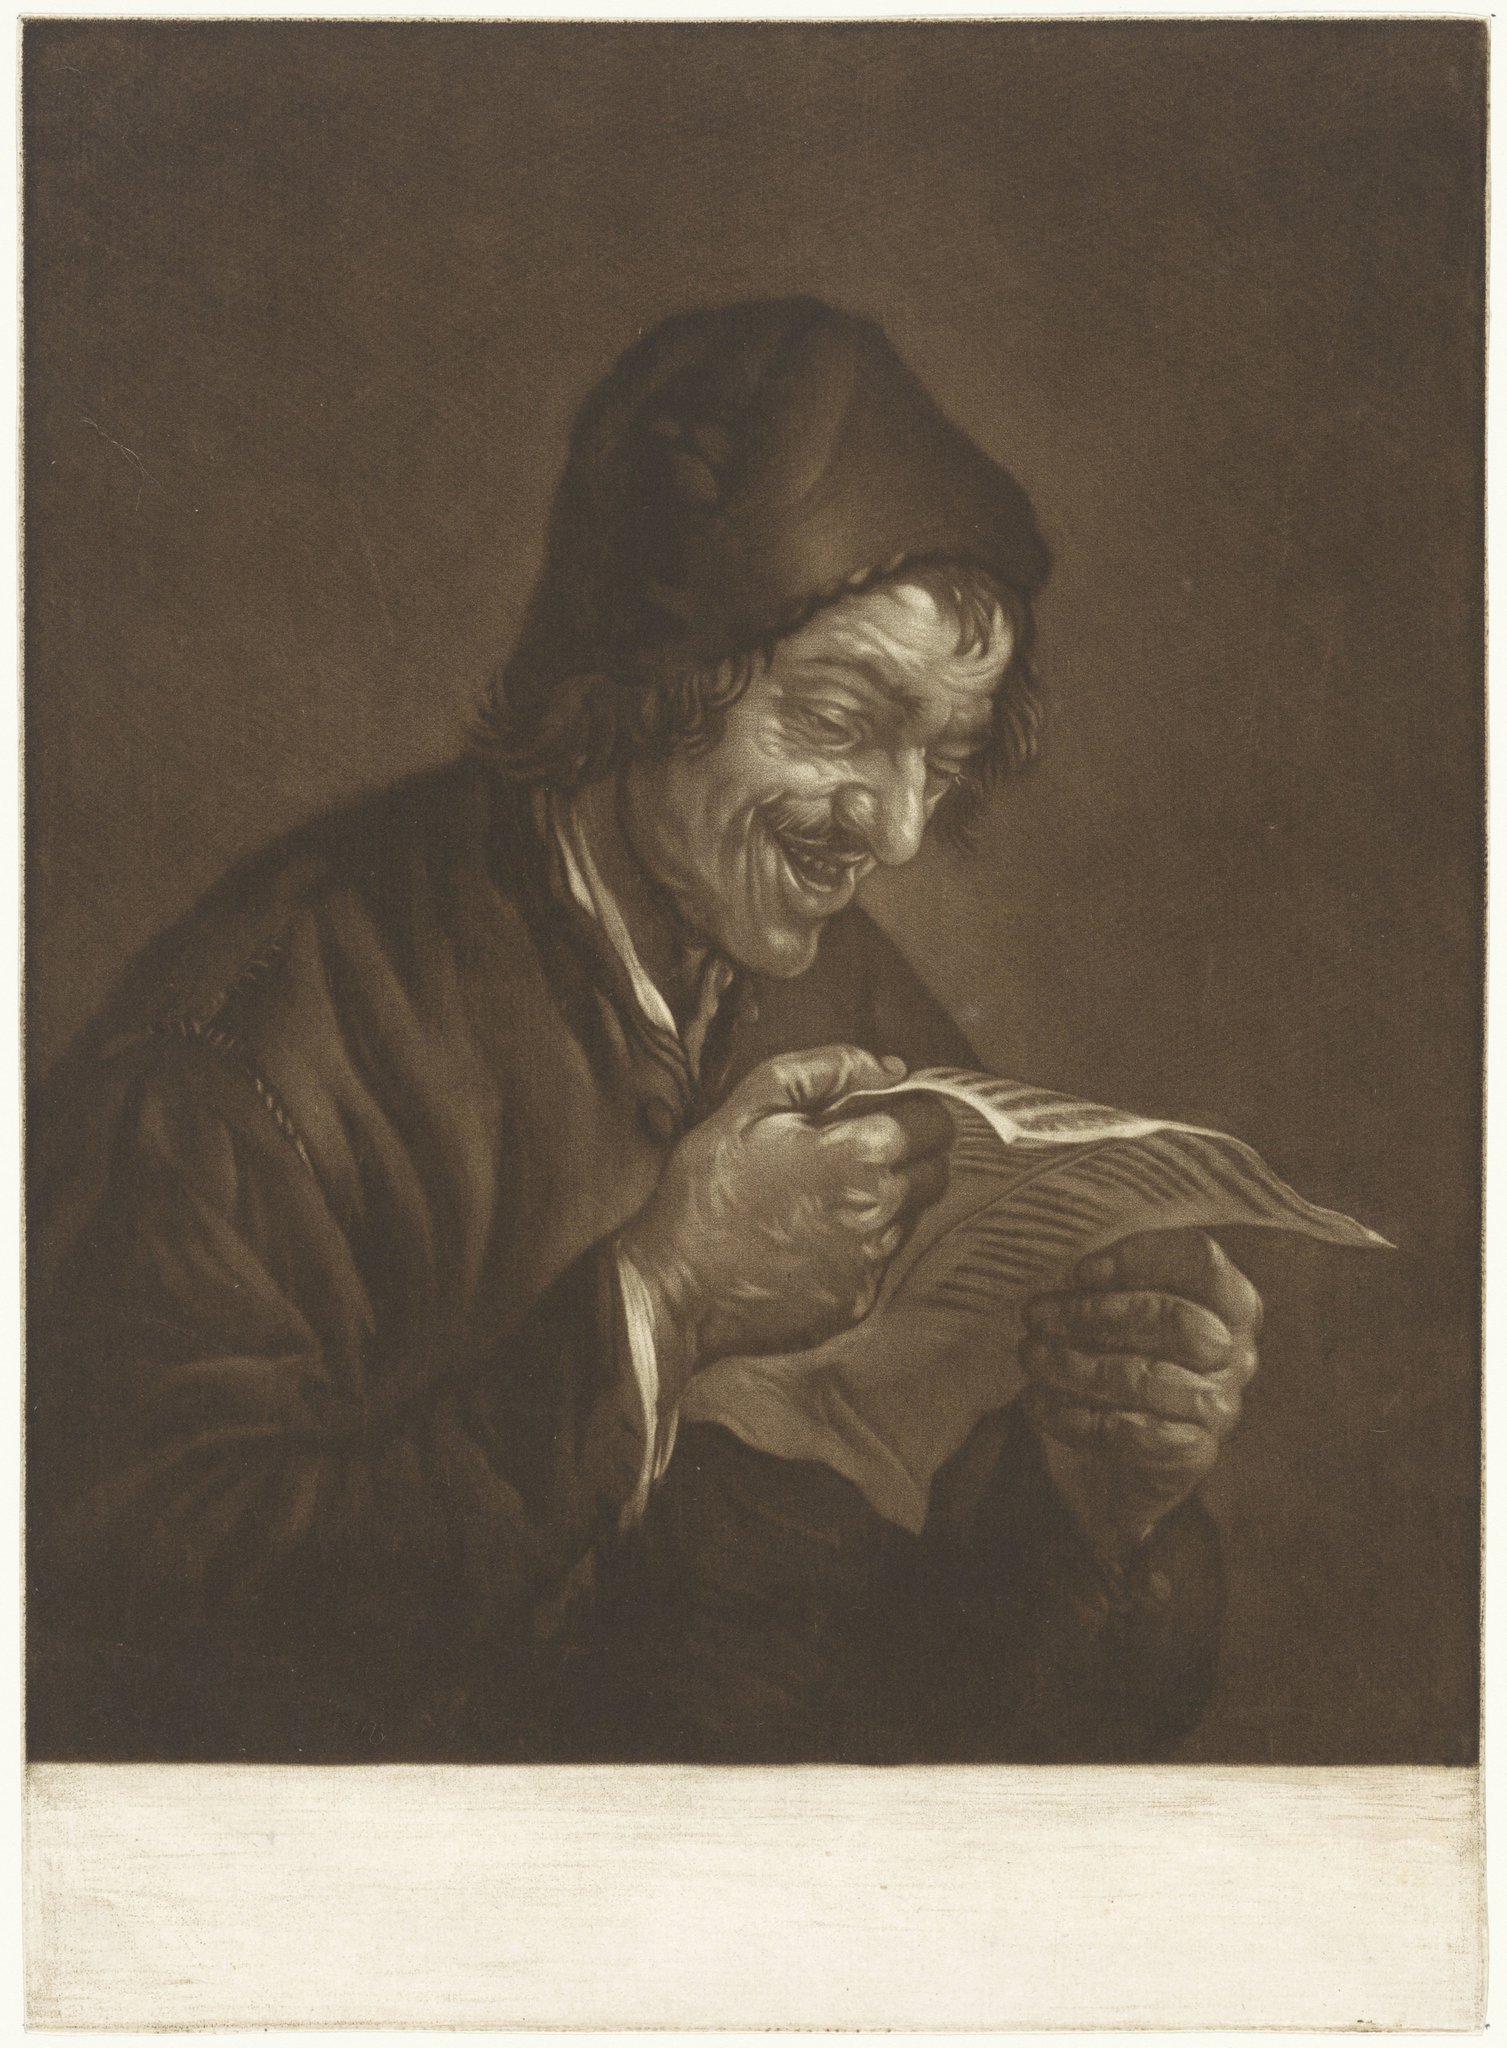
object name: print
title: Lezende man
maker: jan stolker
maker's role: draughtsman, painter, print maker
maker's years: 1724-1785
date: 1734-1785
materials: paper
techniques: mezzotint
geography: northern netherlands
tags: reading, newspaper, news-sheet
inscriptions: collector's mark: Lugt 240